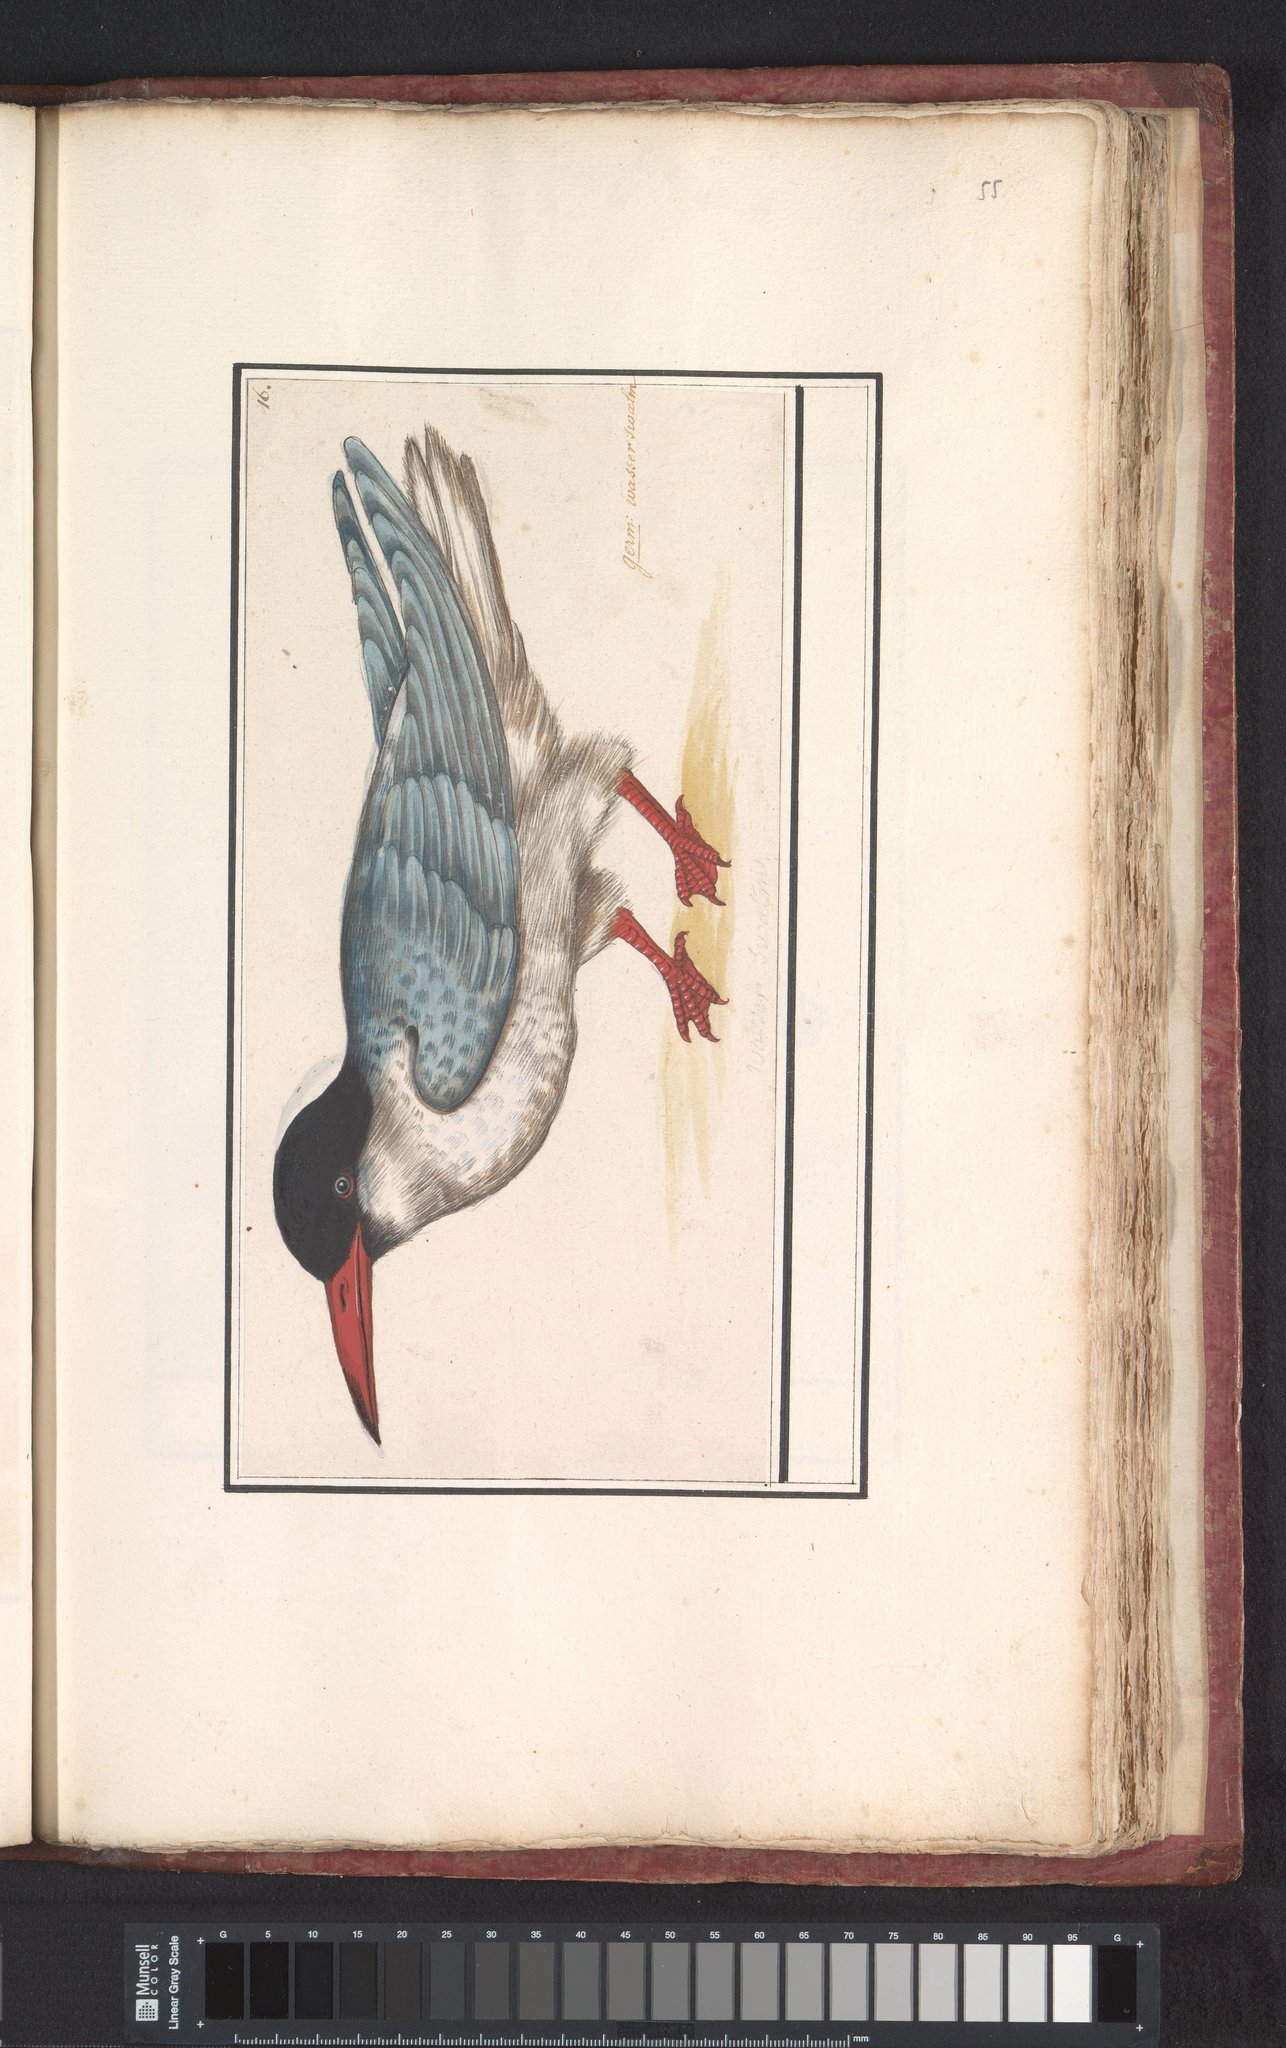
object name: drawing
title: Visdief (Sterna hirundo)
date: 1596-1610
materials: chalk, paint, ink, paper, pencil, watercolor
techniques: brush, pen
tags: water-birds: tern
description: Visdief. Genummerd rechtsboven: 16. Rechts de Duitse naam. Onderdeel van het derde album met tekeningen van vogels. Vijfde van twaalf albums met tekeningen van dieren, vogels en planten bekend rond 1600, gemaakt in opdracht van keizer Rudolf II. Met toelichting in Nederlands, Latijn en Frans.